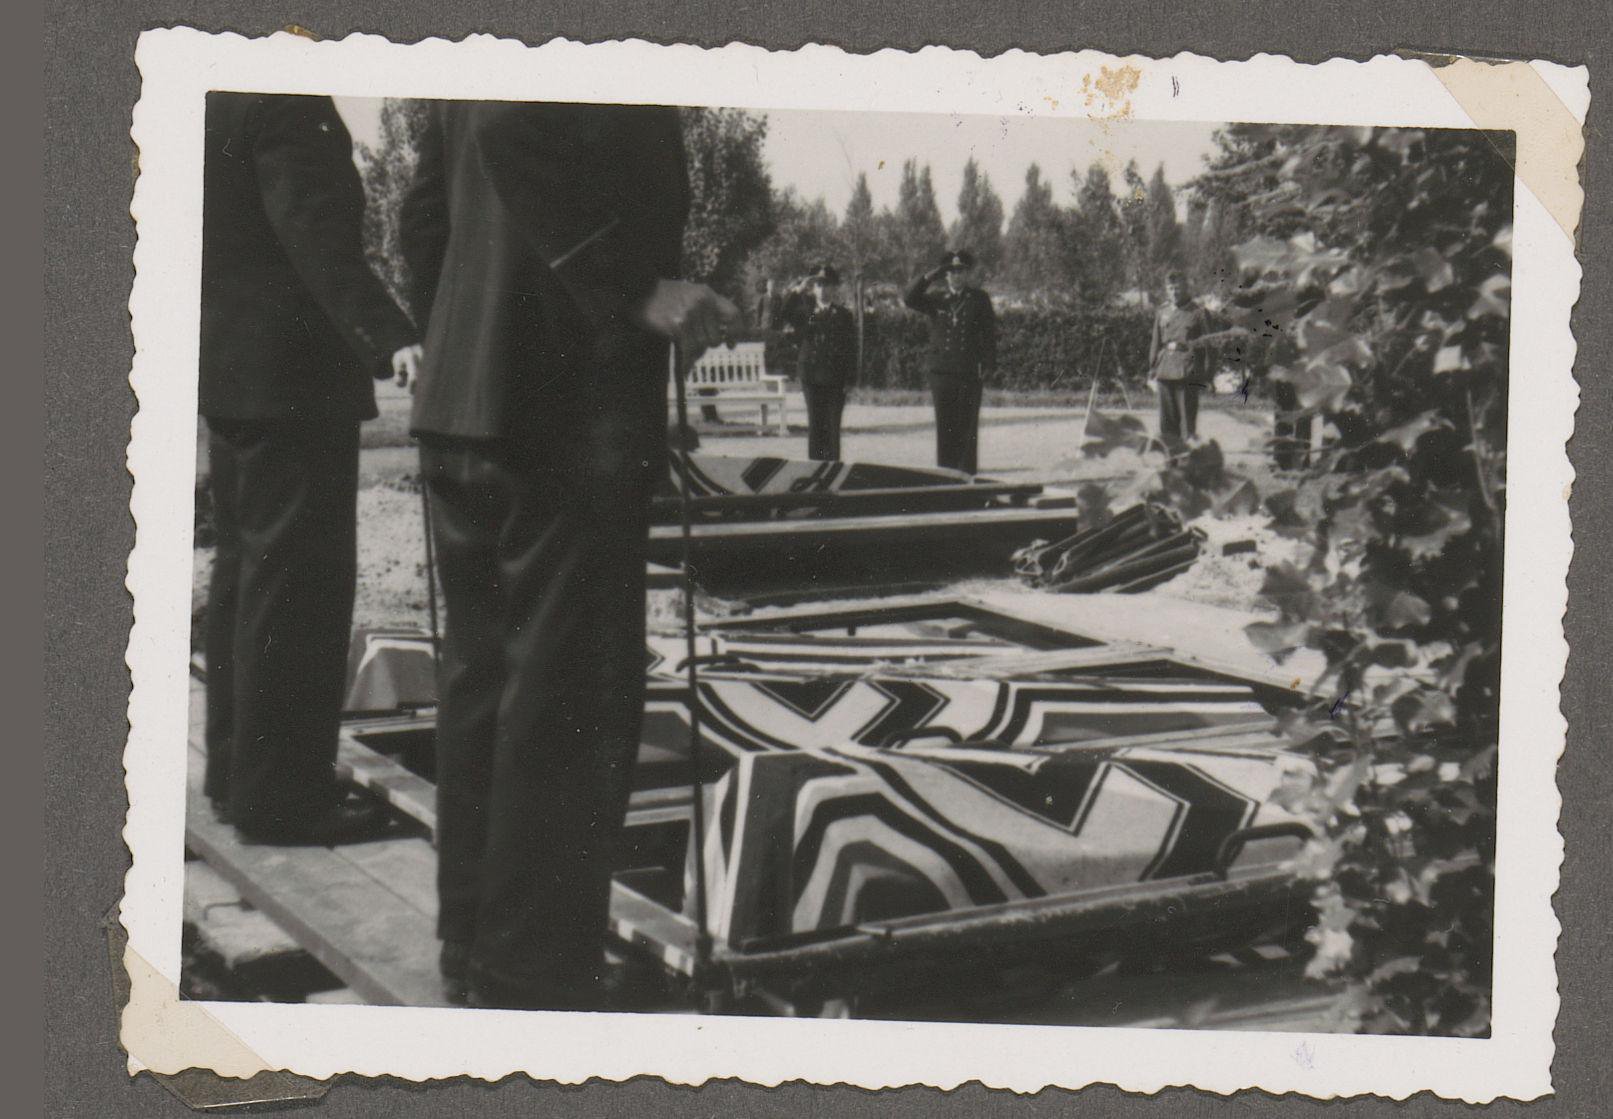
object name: photograph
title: Begrafenis van drie gevallen soldaten met hakenkruisvlaggen over de kisten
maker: Anonymous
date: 1941-1945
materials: paper, photographic support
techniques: gelatin silver print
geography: netherlands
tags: funerary ceremonial, the soldier; the soldier's life, flag, colours (as symbol of the state, etc.)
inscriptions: annotation: ‘Beisetung der 3 Gefallenen/ von Begleitschiff "Alder"/ der 10,5 cm Kanone/ Gefallen auf see durch Jabo am 15-10-43/ vor Hoek van Holland: [...]P. . R. Feindt/ [...] Ob Gfr. Burghordt/ [...] Ob Gfr. Herrmann’